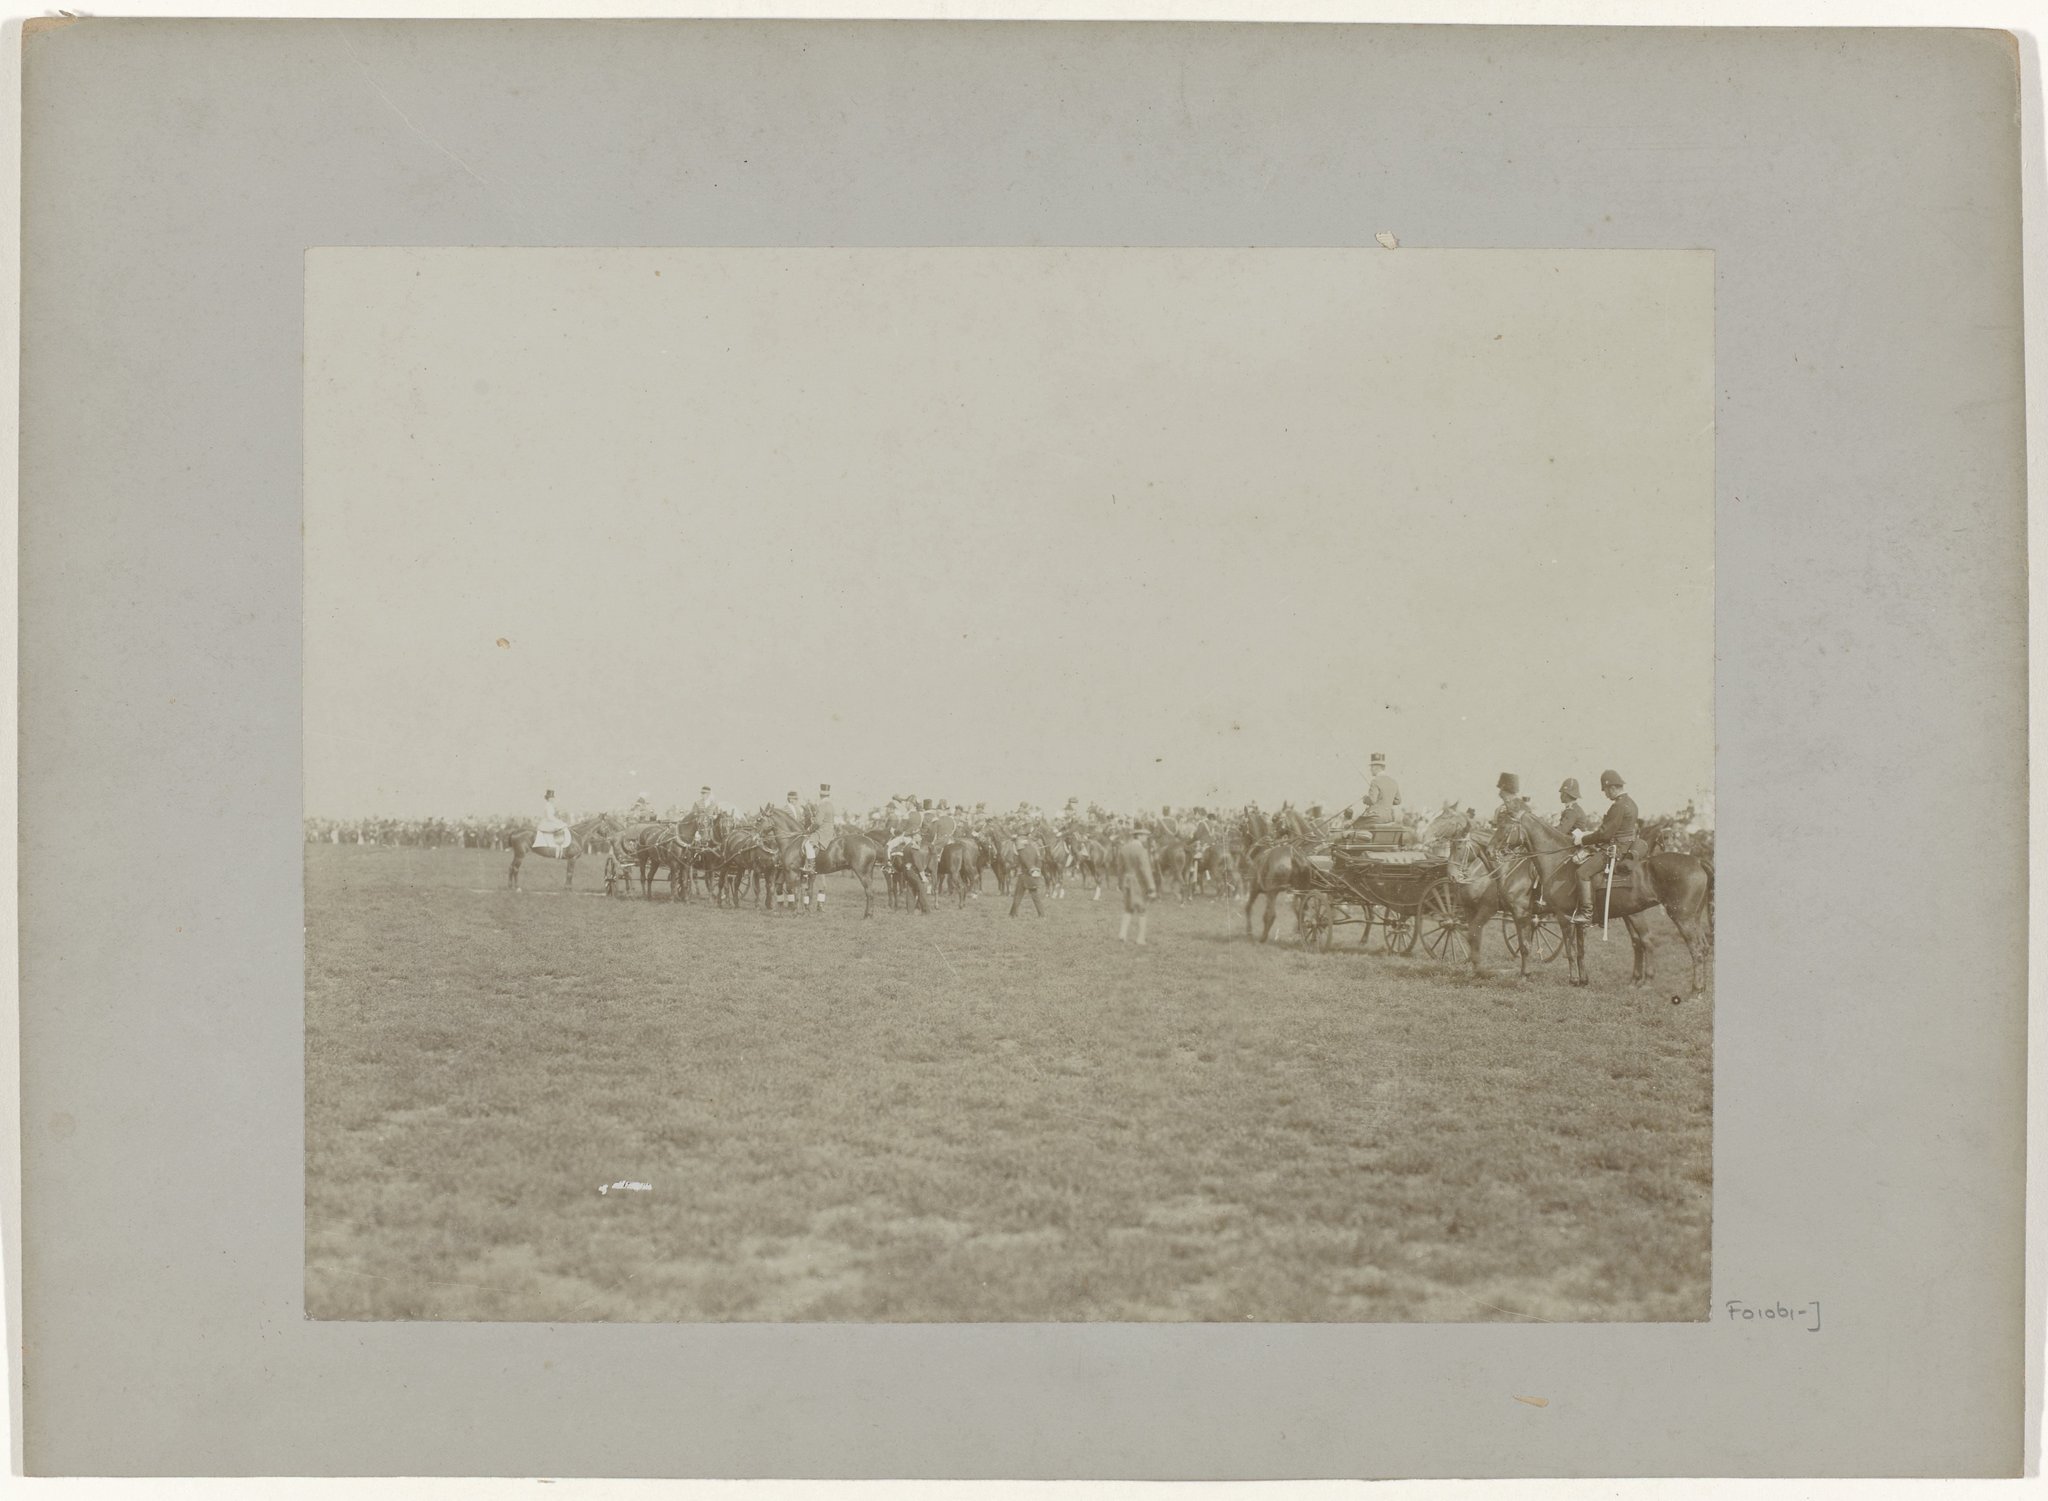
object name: photograph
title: Koningin Wilhelmina bezoekt legerrevue op de Renkumer Heide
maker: barend groote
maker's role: fotograaf, fotohandel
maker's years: 1862-1946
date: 1898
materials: photographic support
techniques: collodion silver print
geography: renkum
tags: the hague, print maker, wilhelmina of the netherlands, riding a horse, ass, or mule; rider, horseman, ceremonial celebration of installation of a ruler, public festivities on the occasion of royal events, review, inspection (of company, unit, troop), installation of a ruler - bb - female ruler, horse, dress, gown, (military) uniforms, head-gear: top hat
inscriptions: name: ‘B. Groote & Co. Kalverstraat 43 Amsterdam’, inscription: ‘Legerrevue op de Renkumer Heide 21 september 1898’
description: Onderdeel van Fotoalbum met tien opnames van de inhuldiging van koningin Wilhelmina en de inhuldigingsfeesten.